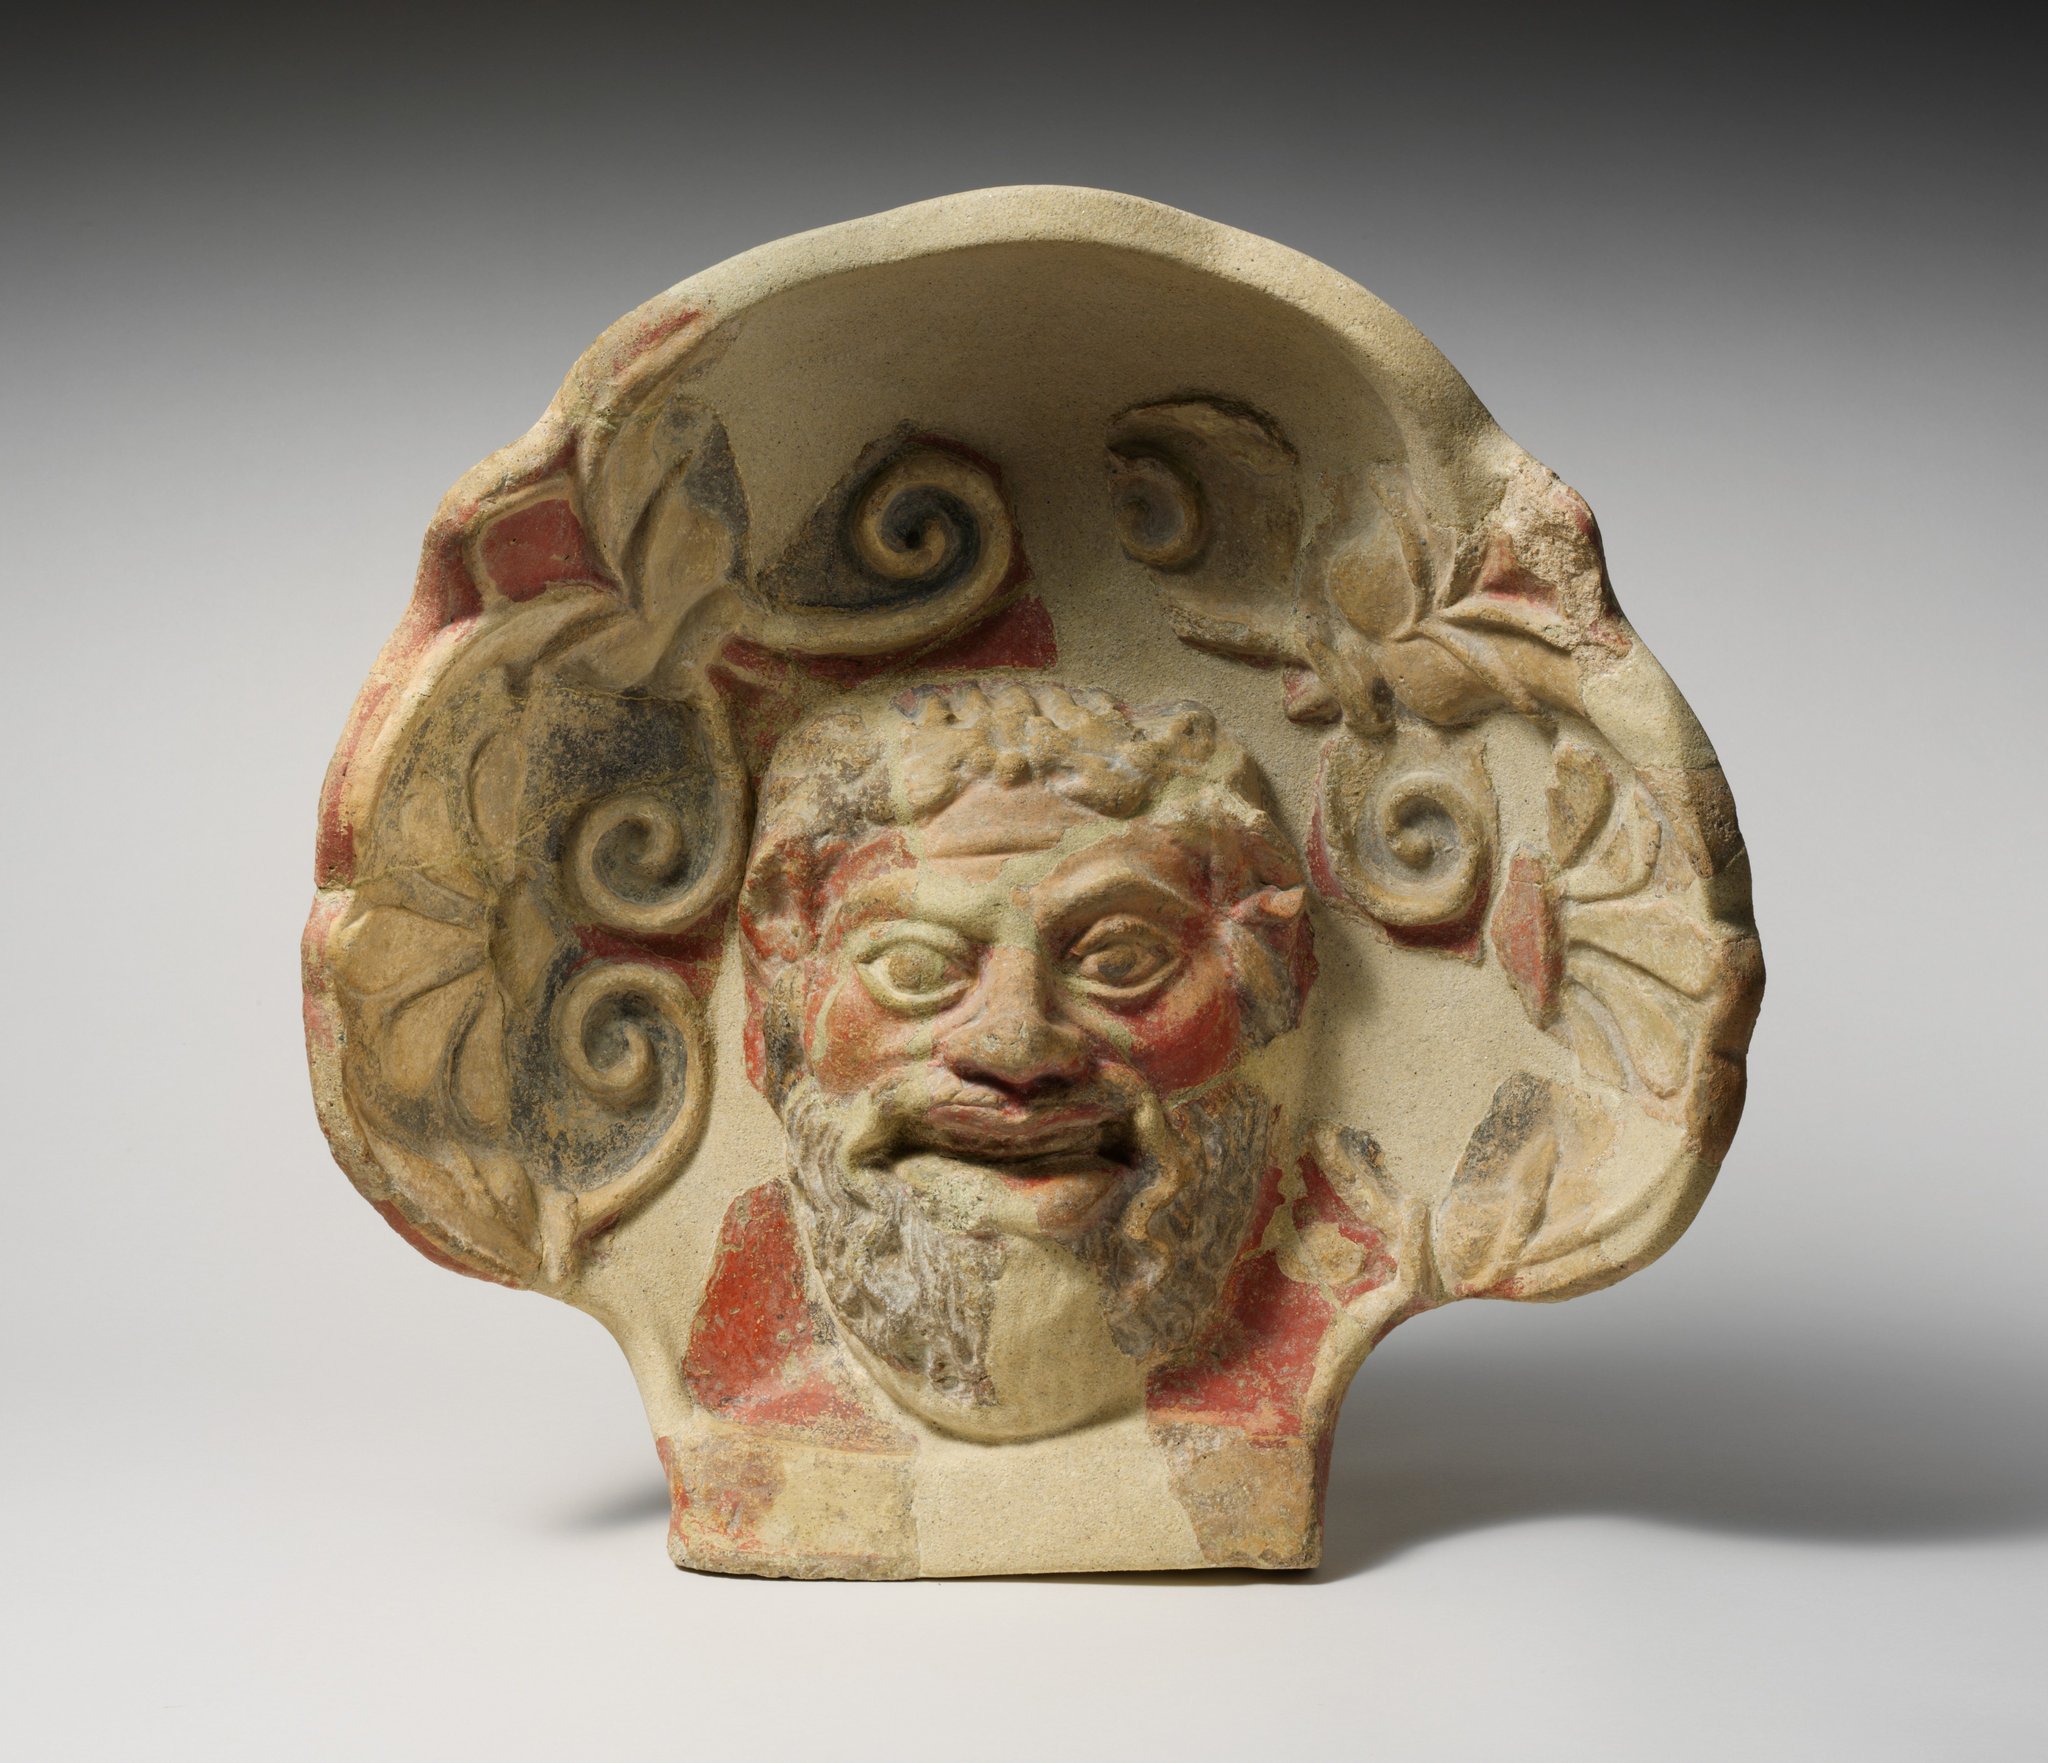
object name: antefix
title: Terracotta antefix (roof tile) with head of a satyr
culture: etruscan, cerveteri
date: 400-301 BCE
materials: terracotta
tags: satyrs